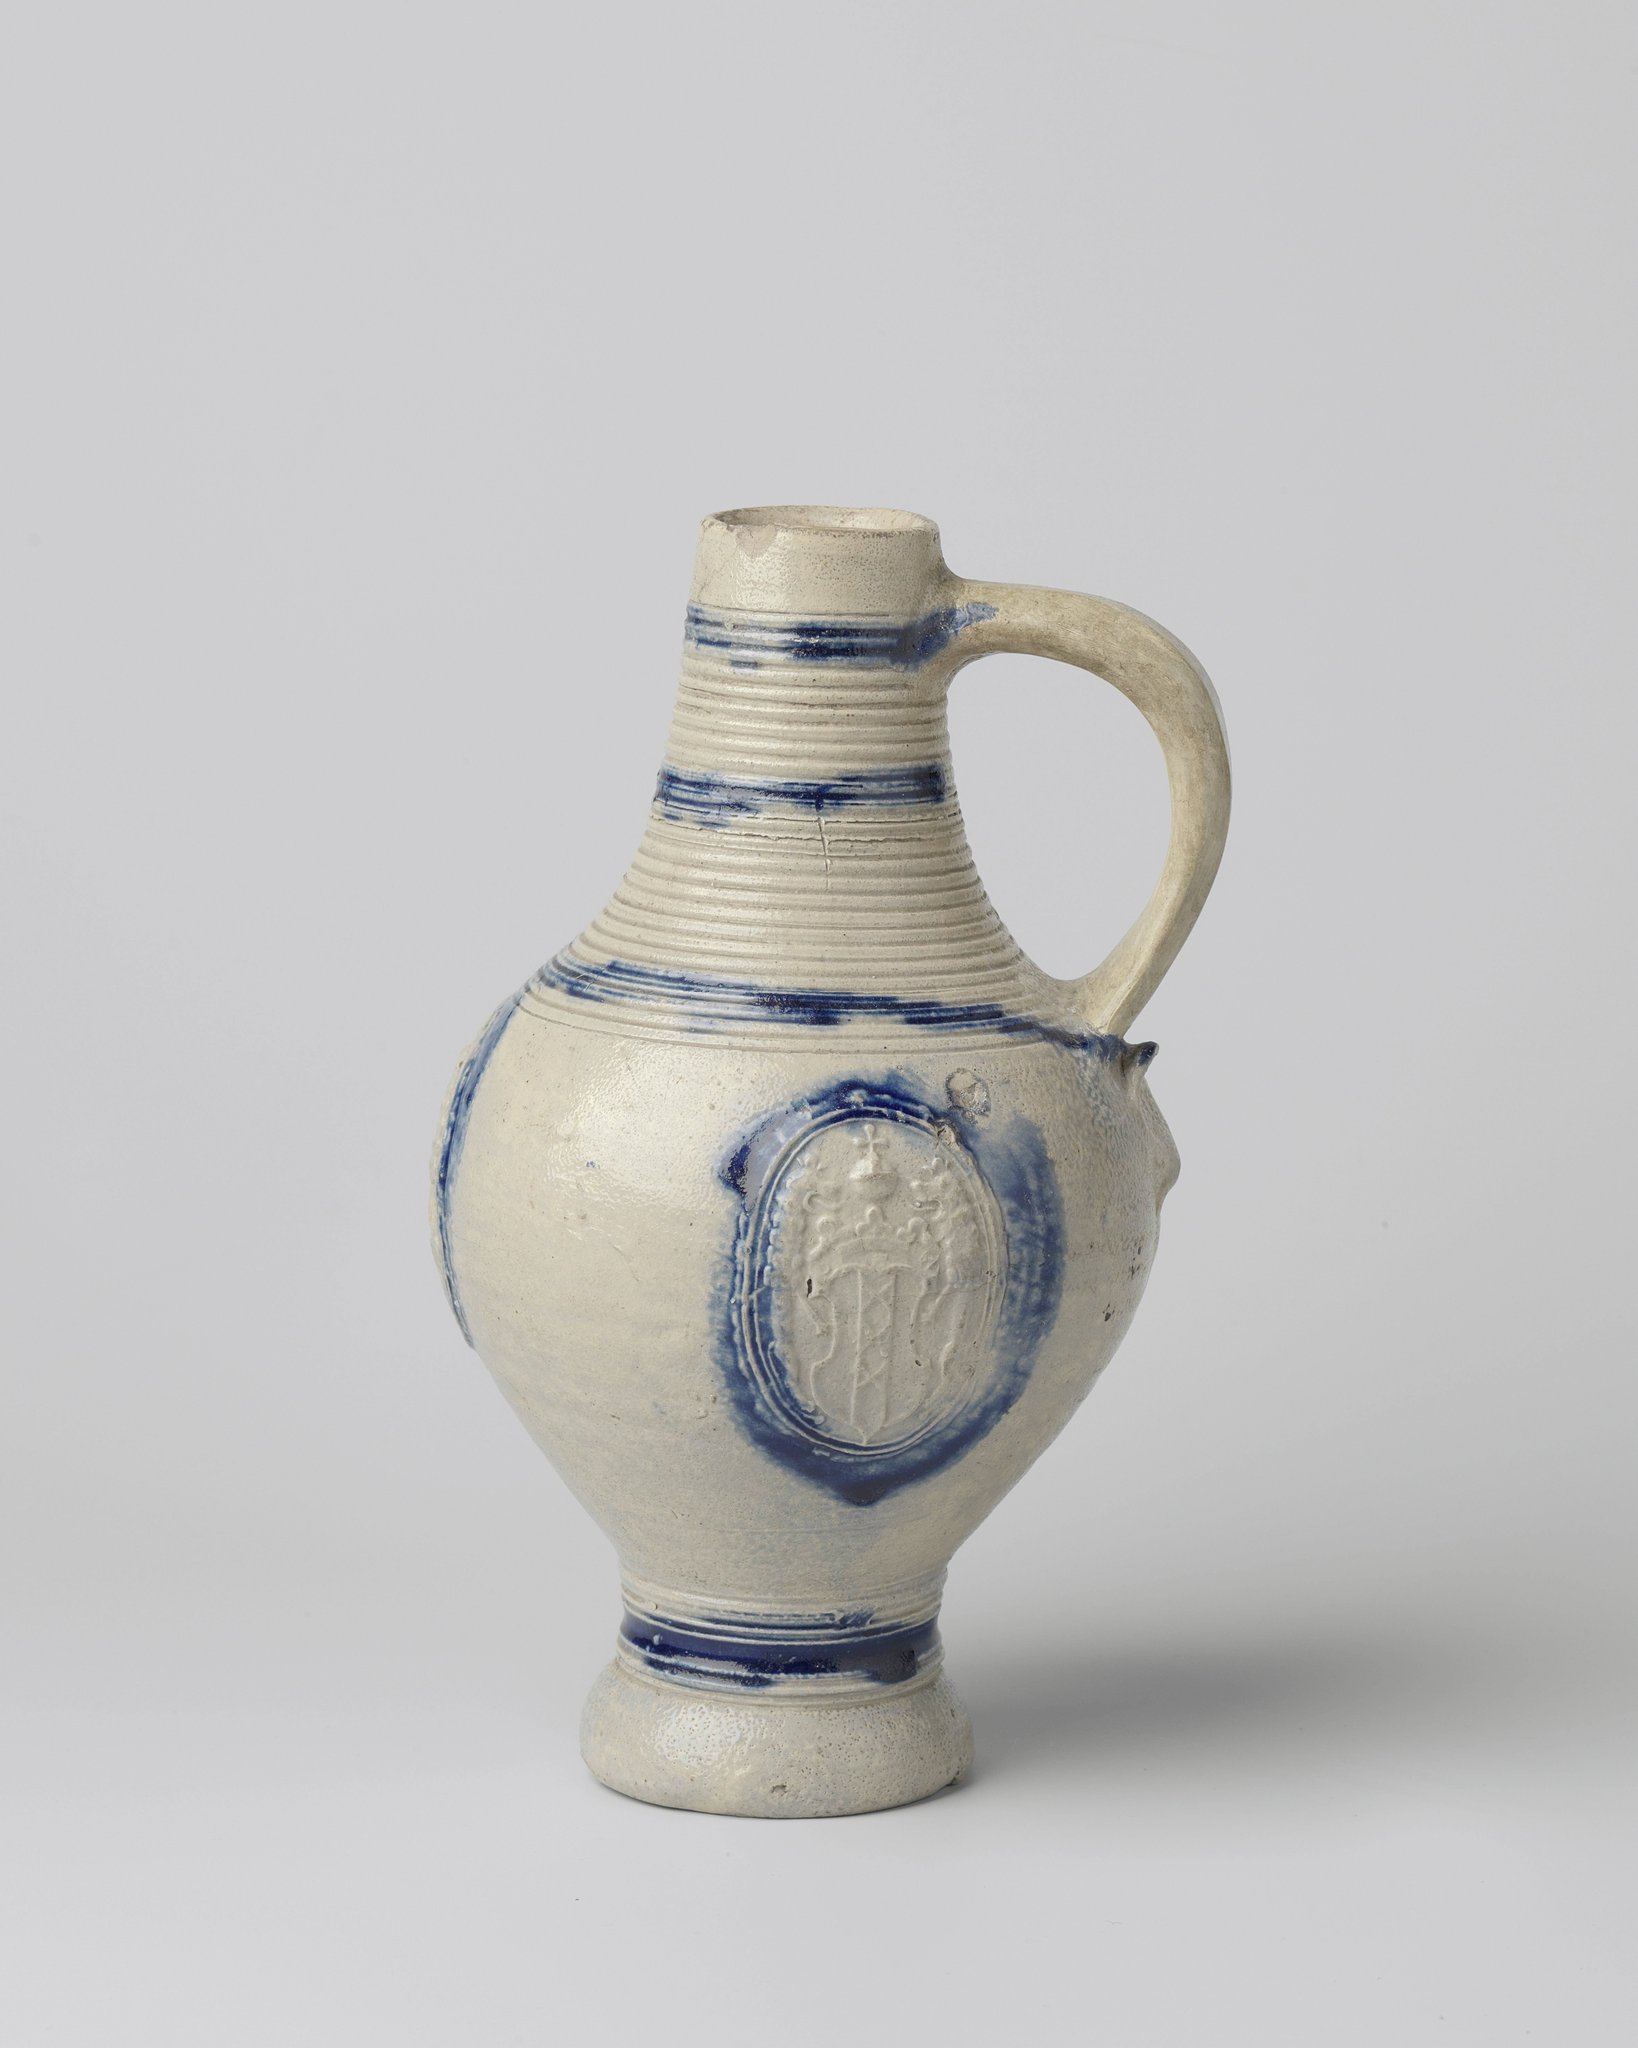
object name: jug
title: Jug with the coat of arms of Amsterdam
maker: Anonymous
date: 1600-1649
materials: cobalt, glaze, stoneware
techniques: firing, forming, relief, turning, vitrification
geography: westerwald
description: Kruik van steengoed op hoge voet met een eivormig lichaam en een taps toelopende nek. Het C-vormige oor is bevestigd aan de nek en de schouder. Een brede band met ingegrifte lijnen op de nek, enkele op de voet. Gedeeltelijk bedekt met kobaltblauw. Op de buik driemaal een gedrukt en opgelegd medaillon met het wapen van Amsterdam in reliëf. Westerwald.